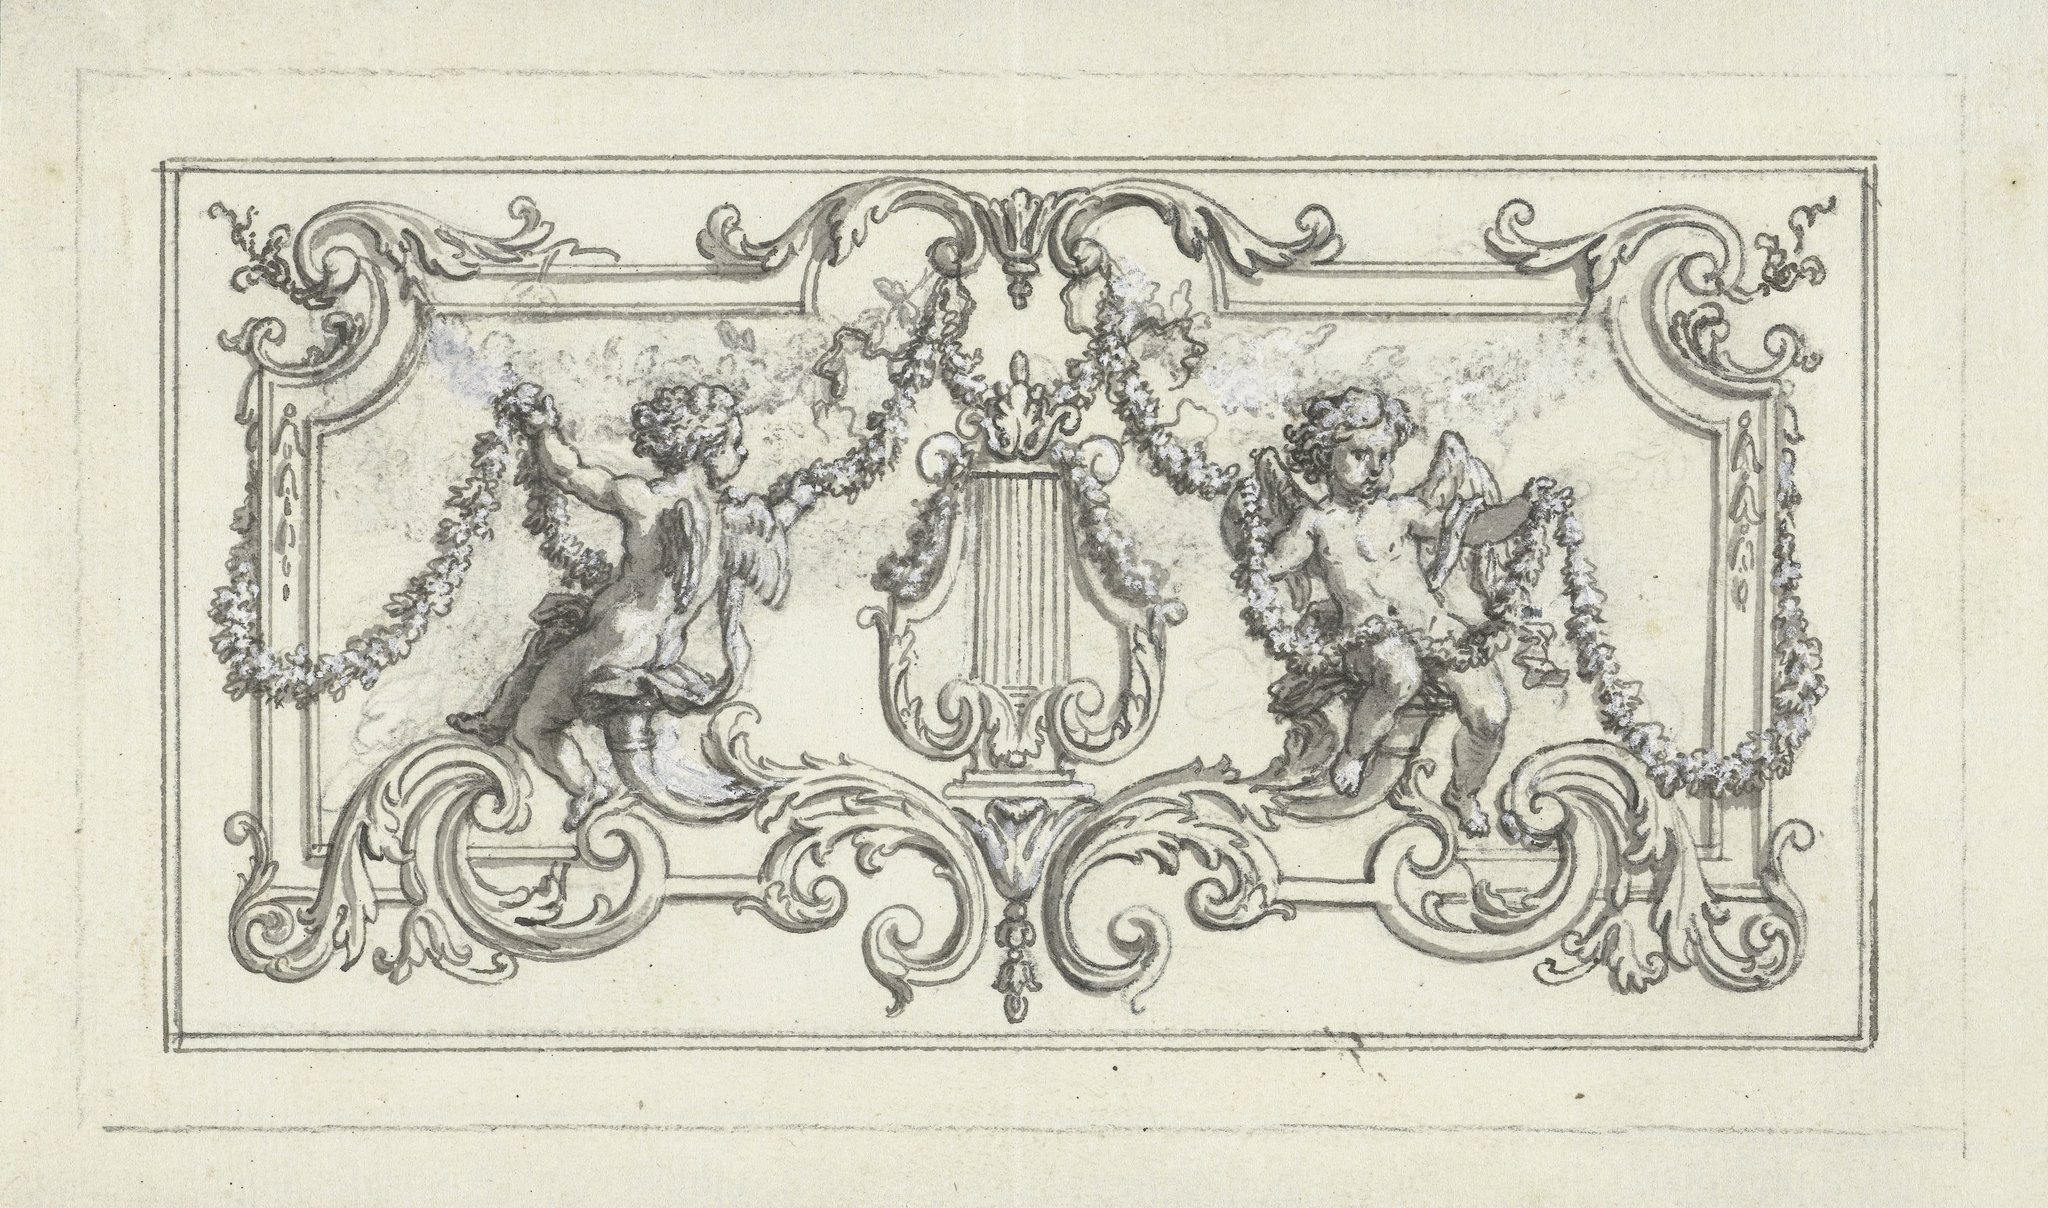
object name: drawing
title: Paneelvulling met putti met guirlandes ter weerszijden van een lier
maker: bernard picart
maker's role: draughtsman, print maker, publisher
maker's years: 1673-1733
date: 1683-1733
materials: paint, ink, paper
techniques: brush, pen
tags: ornaments ~ art